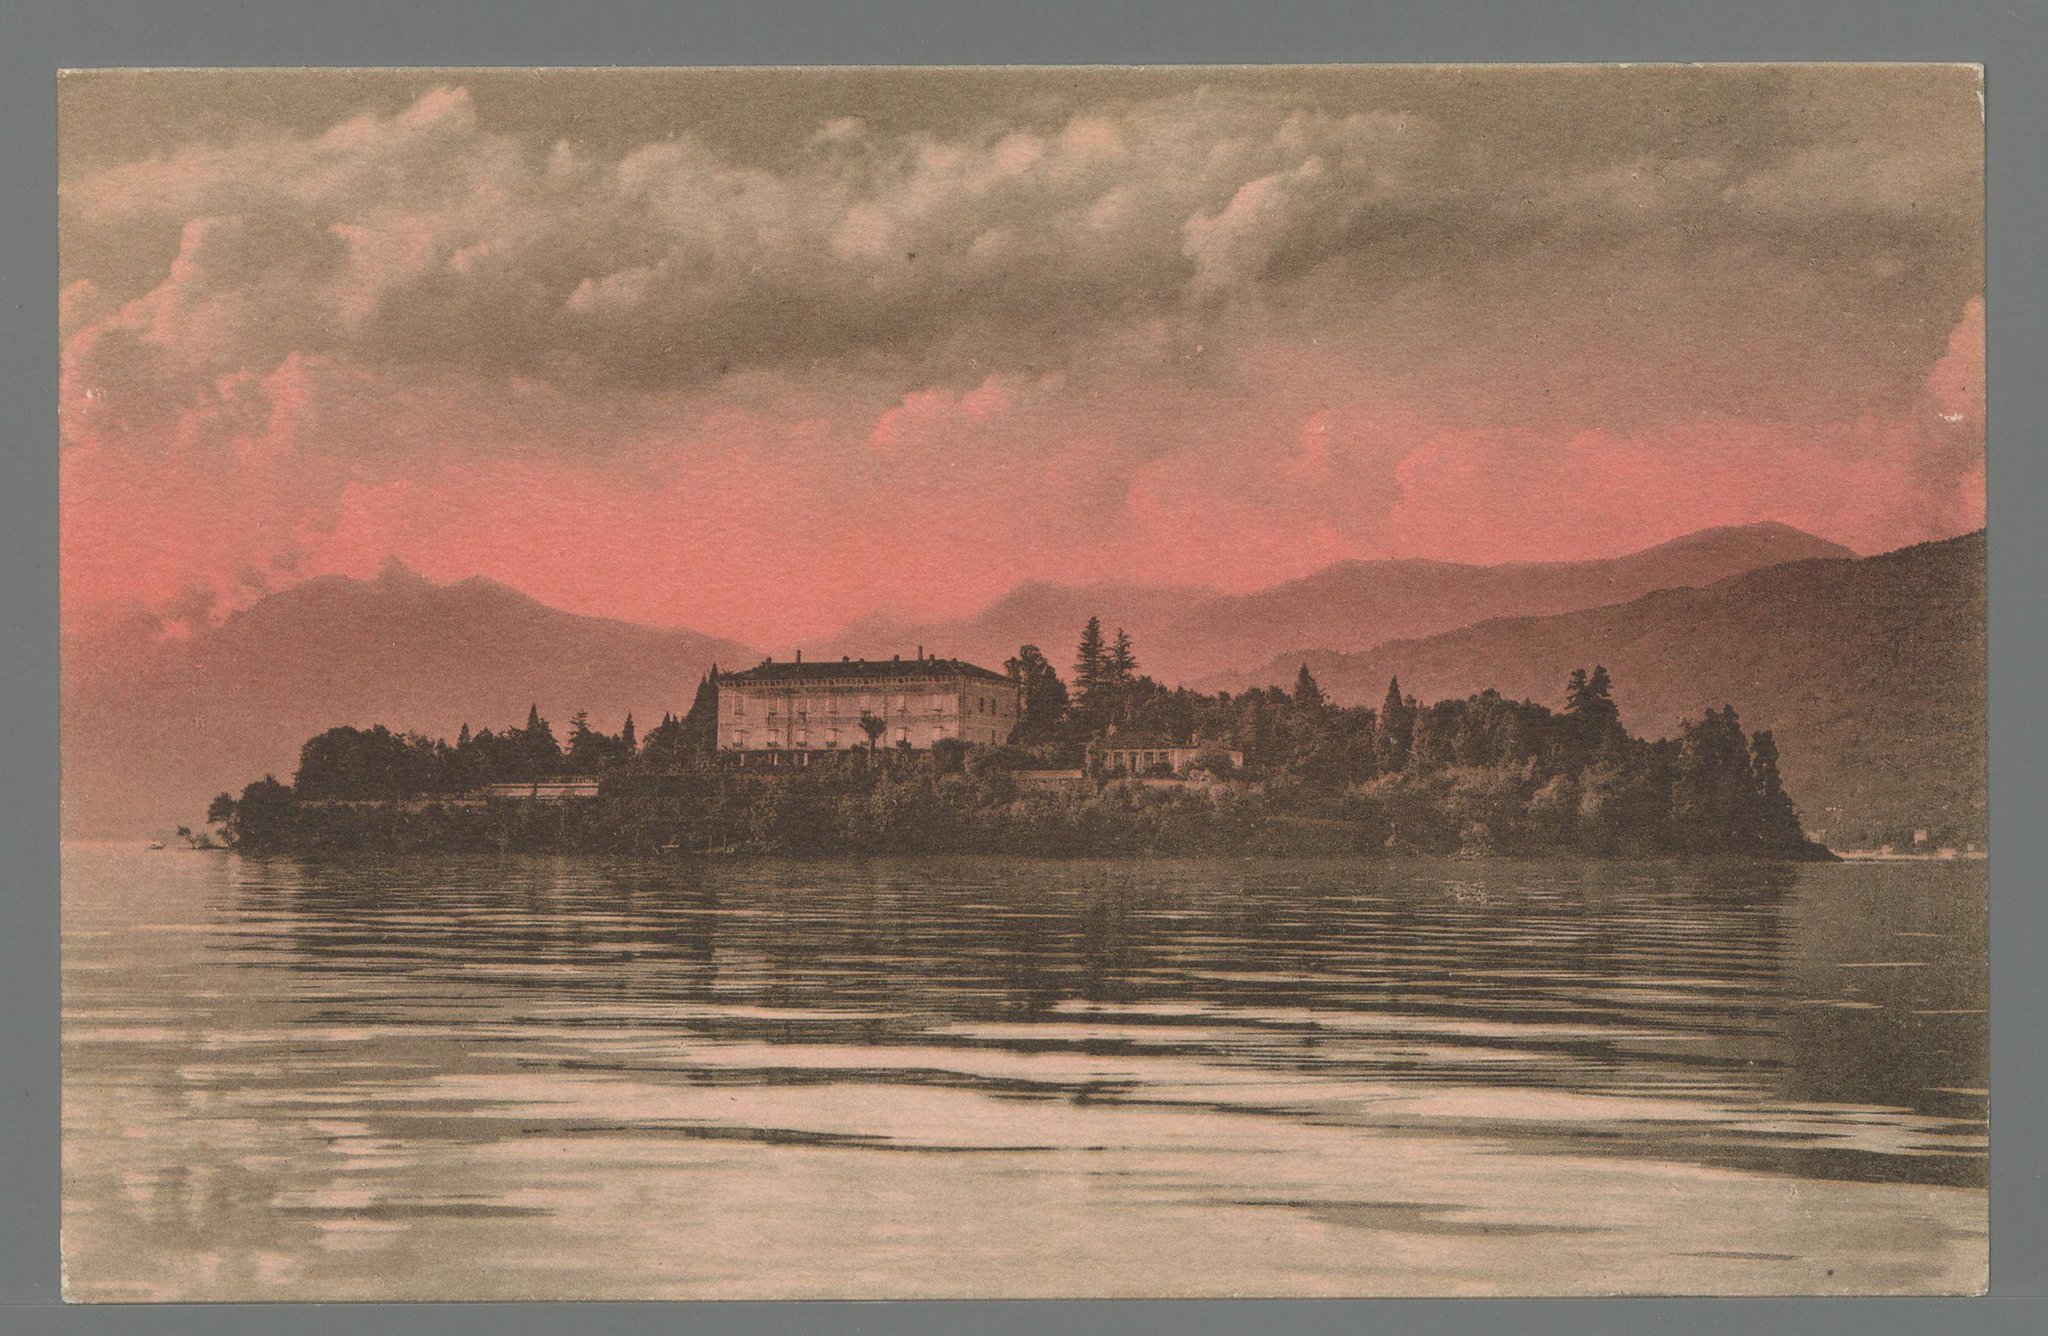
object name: photomechanical print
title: Lago Maggiore. Isola Madre. Tramonto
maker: Anonymous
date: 1905-1909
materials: cardboard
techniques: photograph, lithograph, writing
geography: lake maggiore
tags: island, lake, sunset